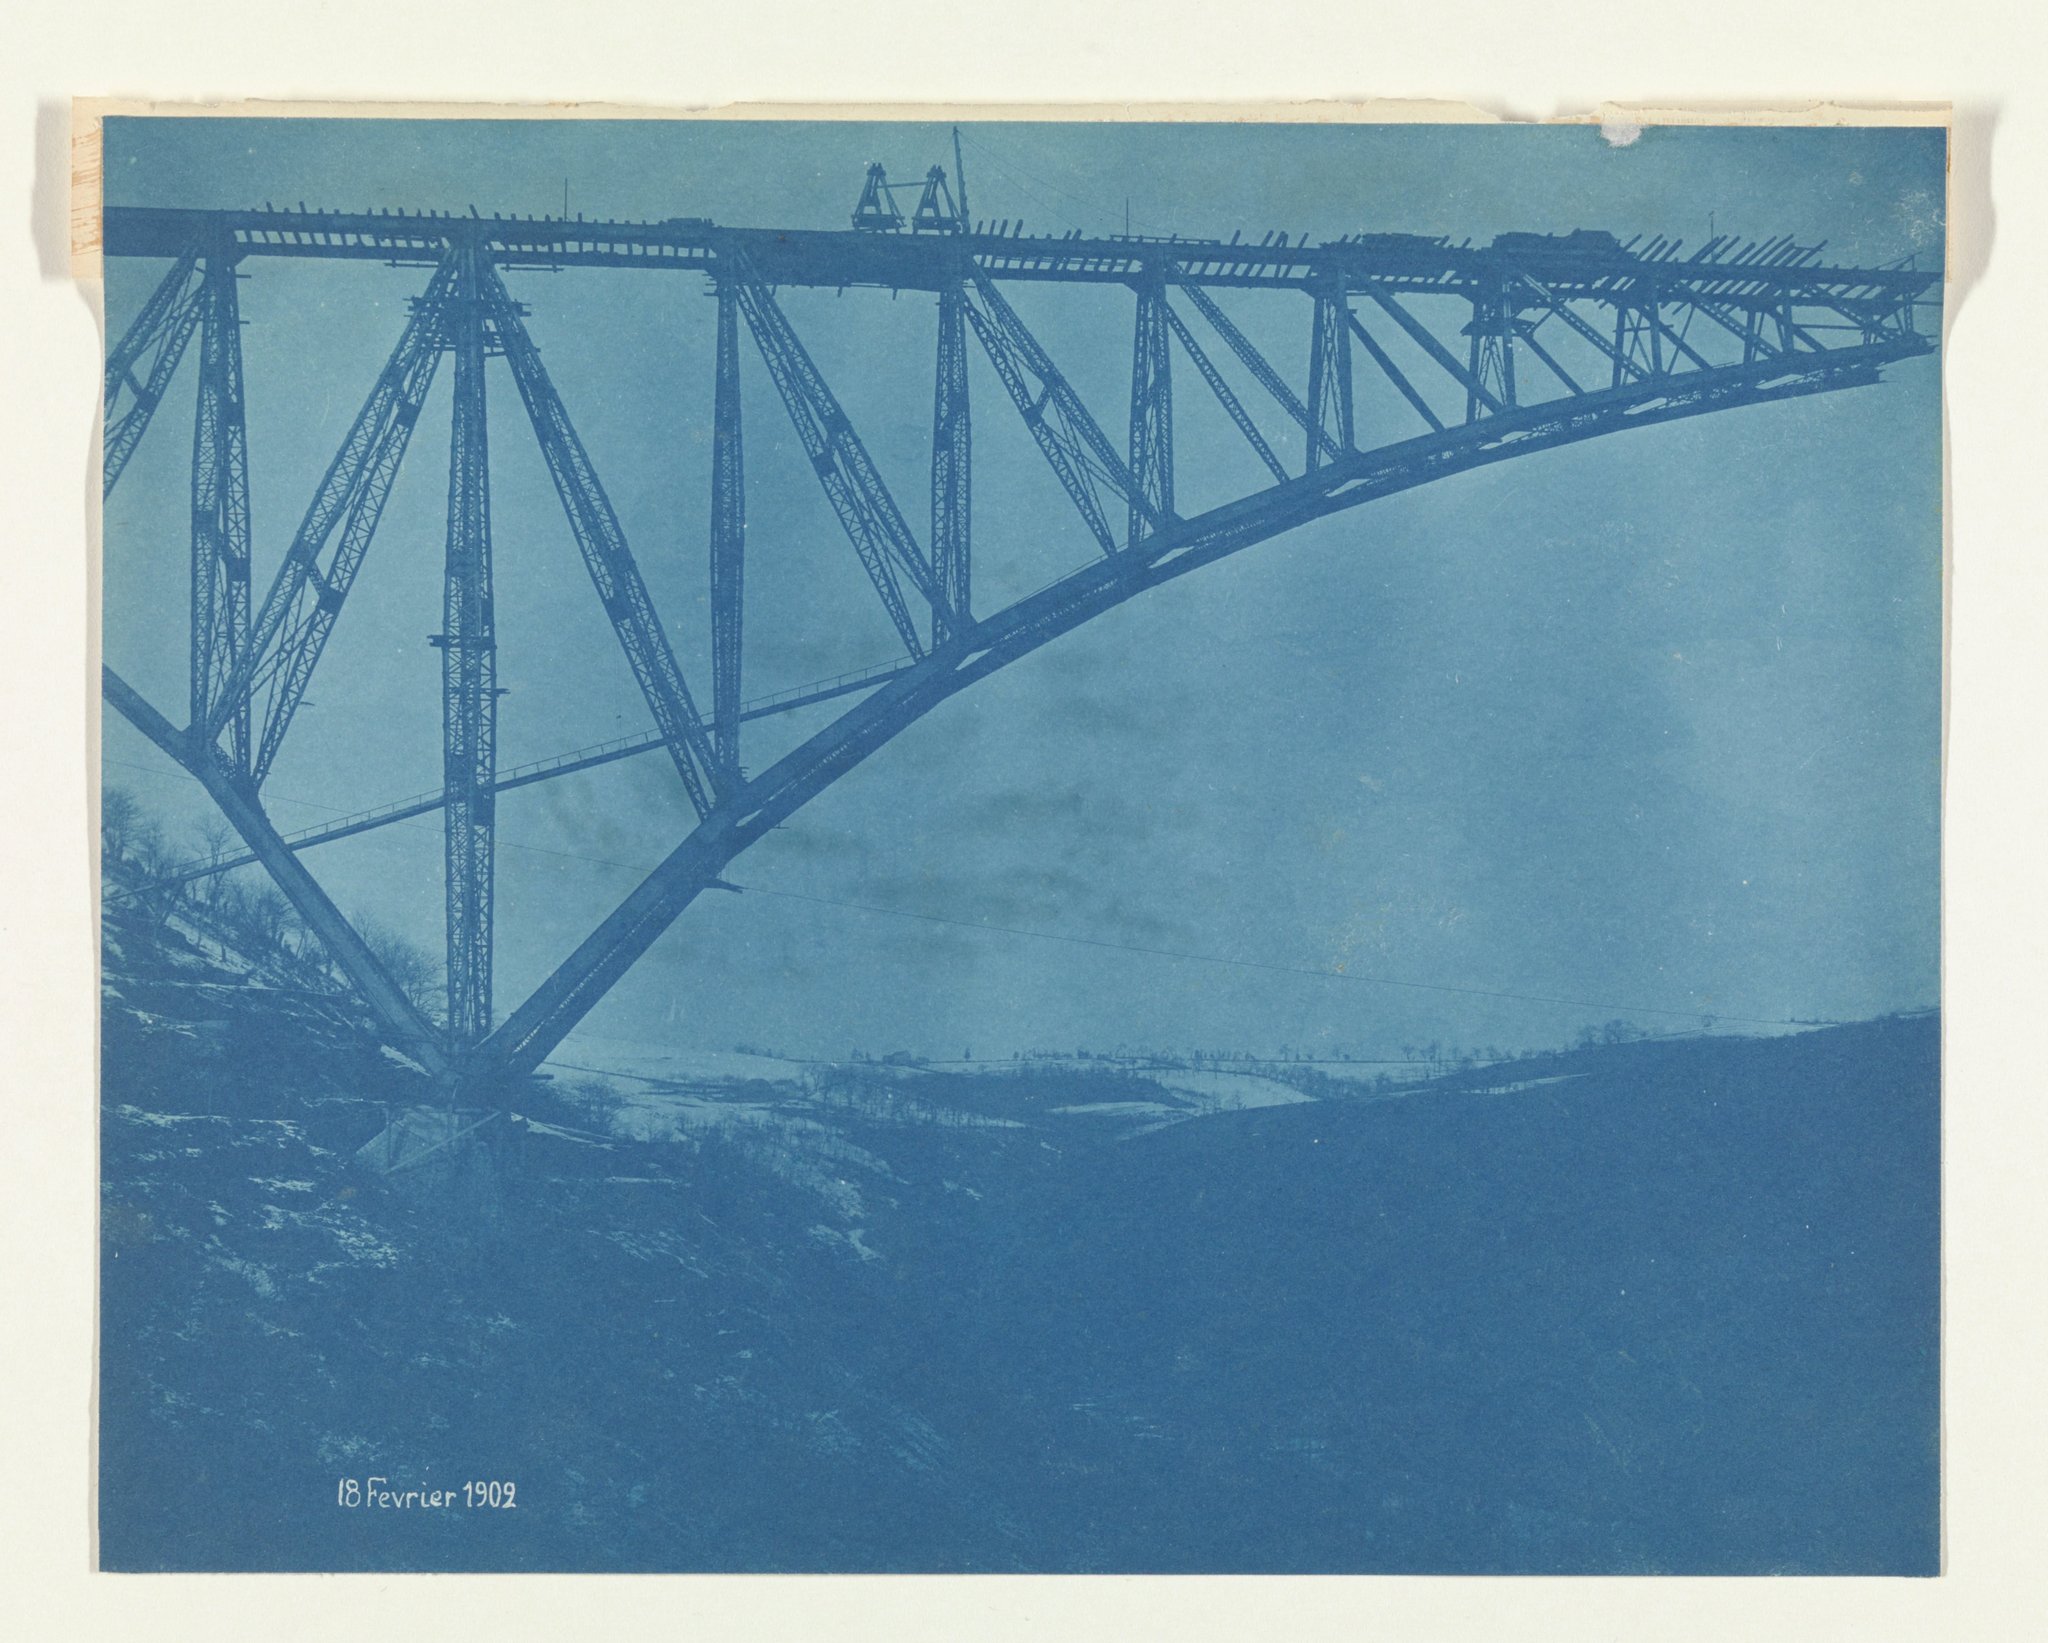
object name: photograph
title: Aanleg van het Viaur Viaduct in Frankrijk door de Societé de Construction des Battignolles, 18 februari 1902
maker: Anonymous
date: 1902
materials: photographic support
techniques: cyanotype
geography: france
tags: viaduct, making the overground structures (~ building activities)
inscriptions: date